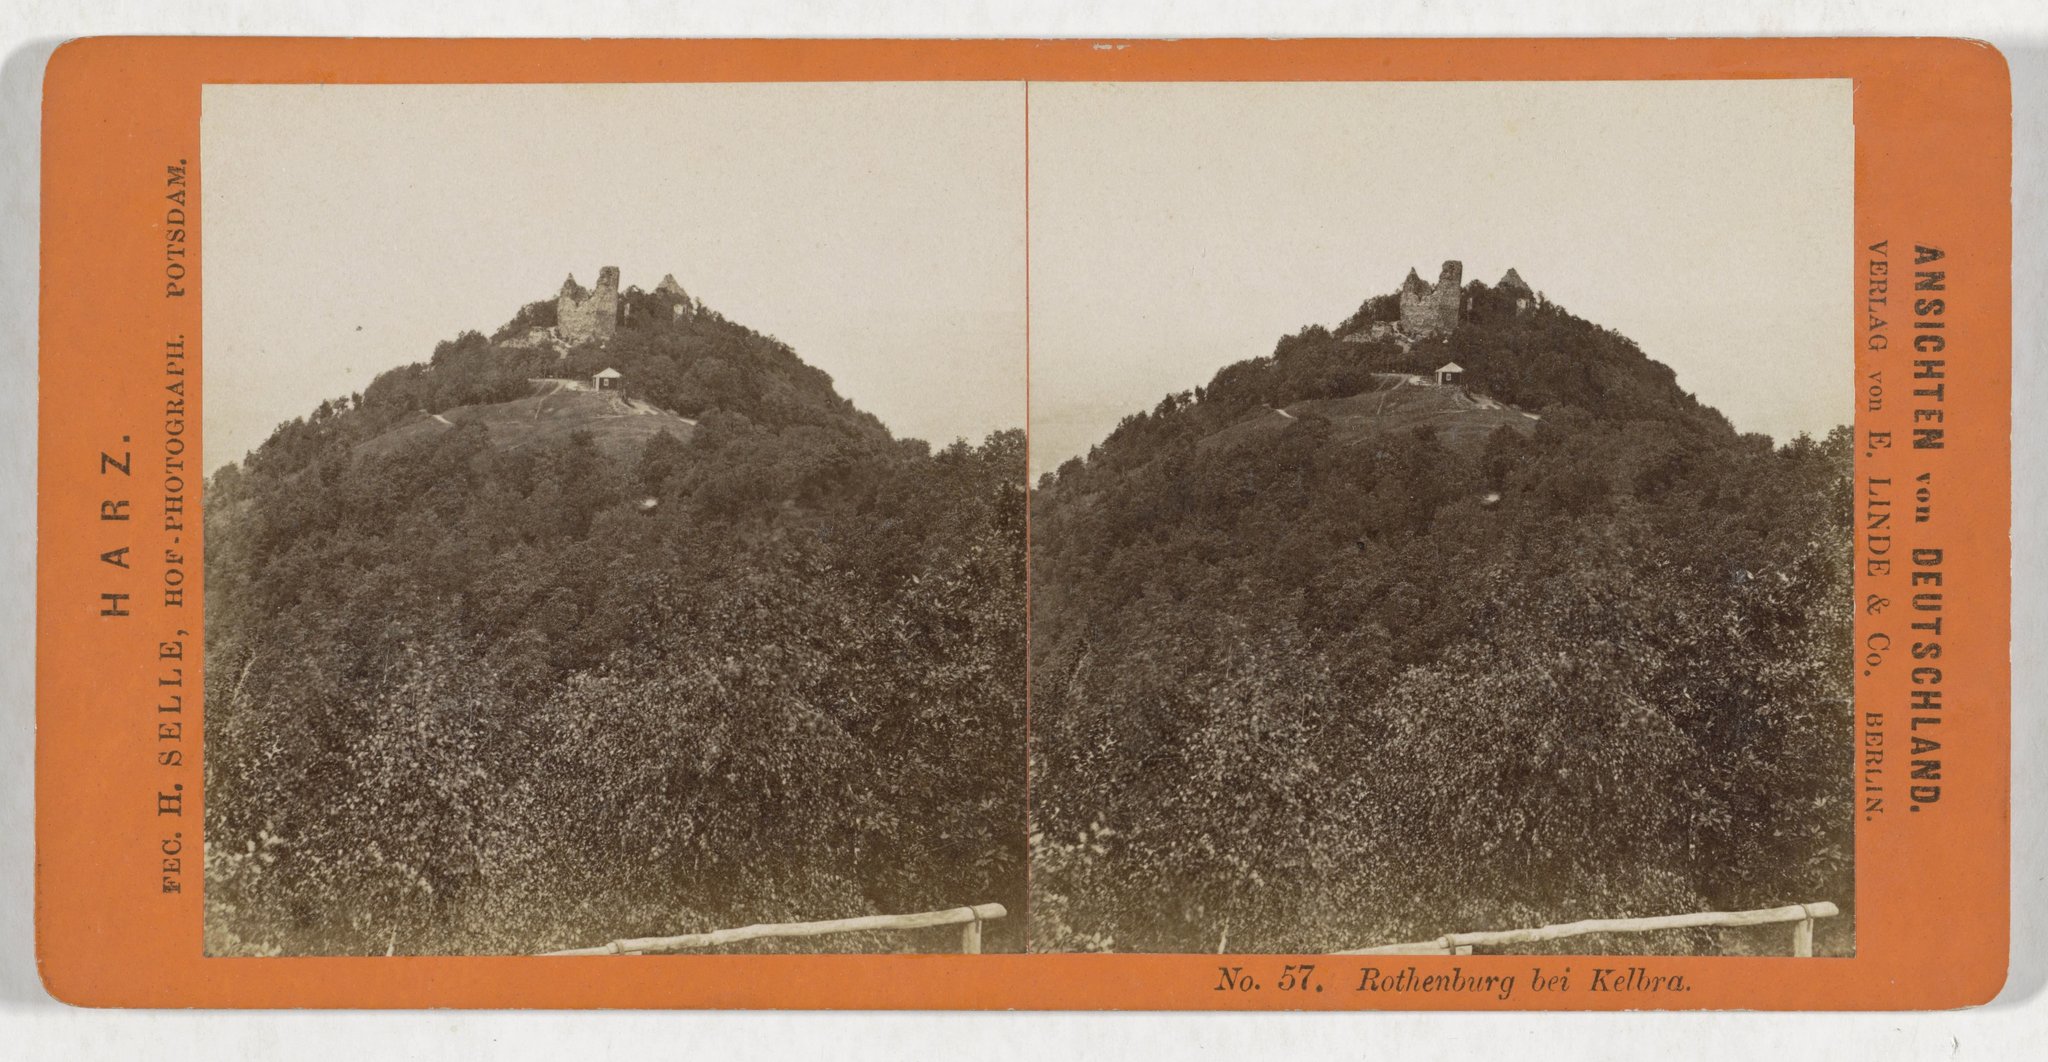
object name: stereograph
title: Gezicht op ruïne Rothenburg, nabij Kelbra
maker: hermann selle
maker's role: fotograaf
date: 1868-1890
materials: cardboard, paper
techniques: albumen print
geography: berlin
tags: landscape with ruins, ruin of a dwelling, house, castle, etc.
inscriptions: number: ‘No. 57.’, inscription: ‘Hof-Photograph. Potsdam.’